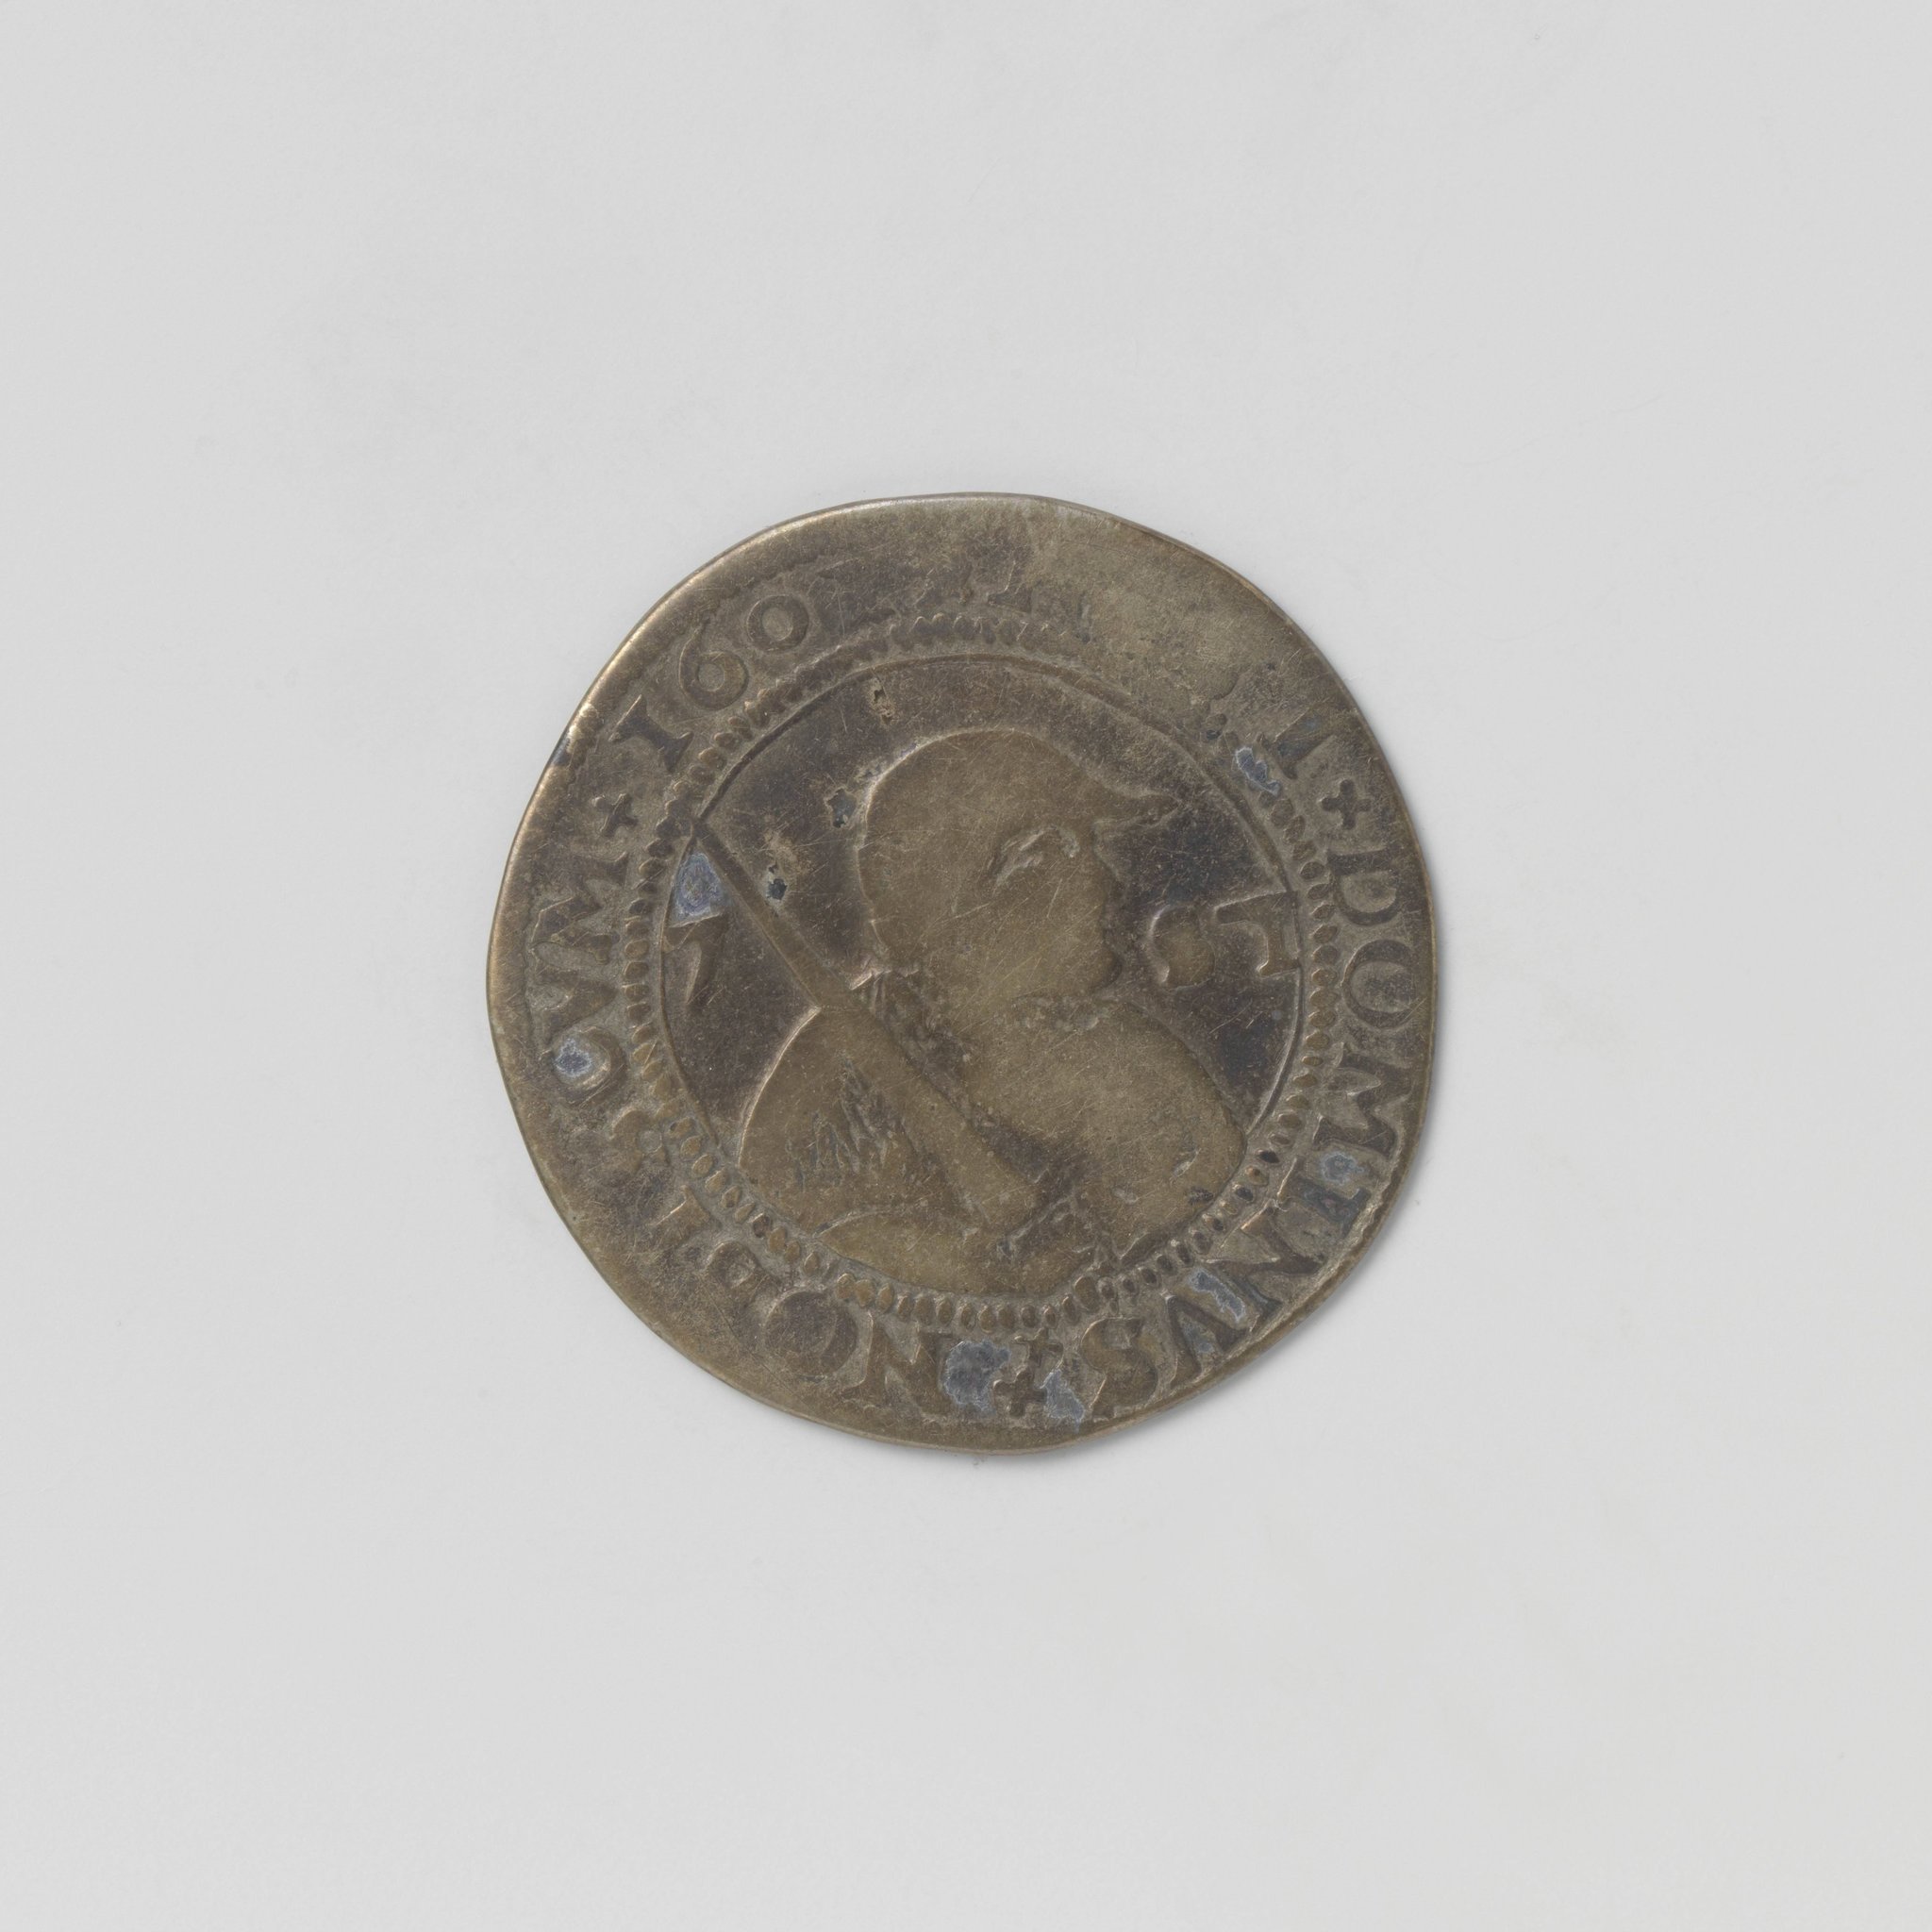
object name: coin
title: Friesland, kwart florijn, 1601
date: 1601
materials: silver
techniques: striking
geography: leeuwarden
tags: friesland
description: Voorzijde: tussen waarde-aanduiding: 7 ST edelman met muts naar rechts. In rechterhand zwaard. Jaartal in omschrift. Keerzijde: op kort gebloemd kruis gekroond wapenschild van Friesland.